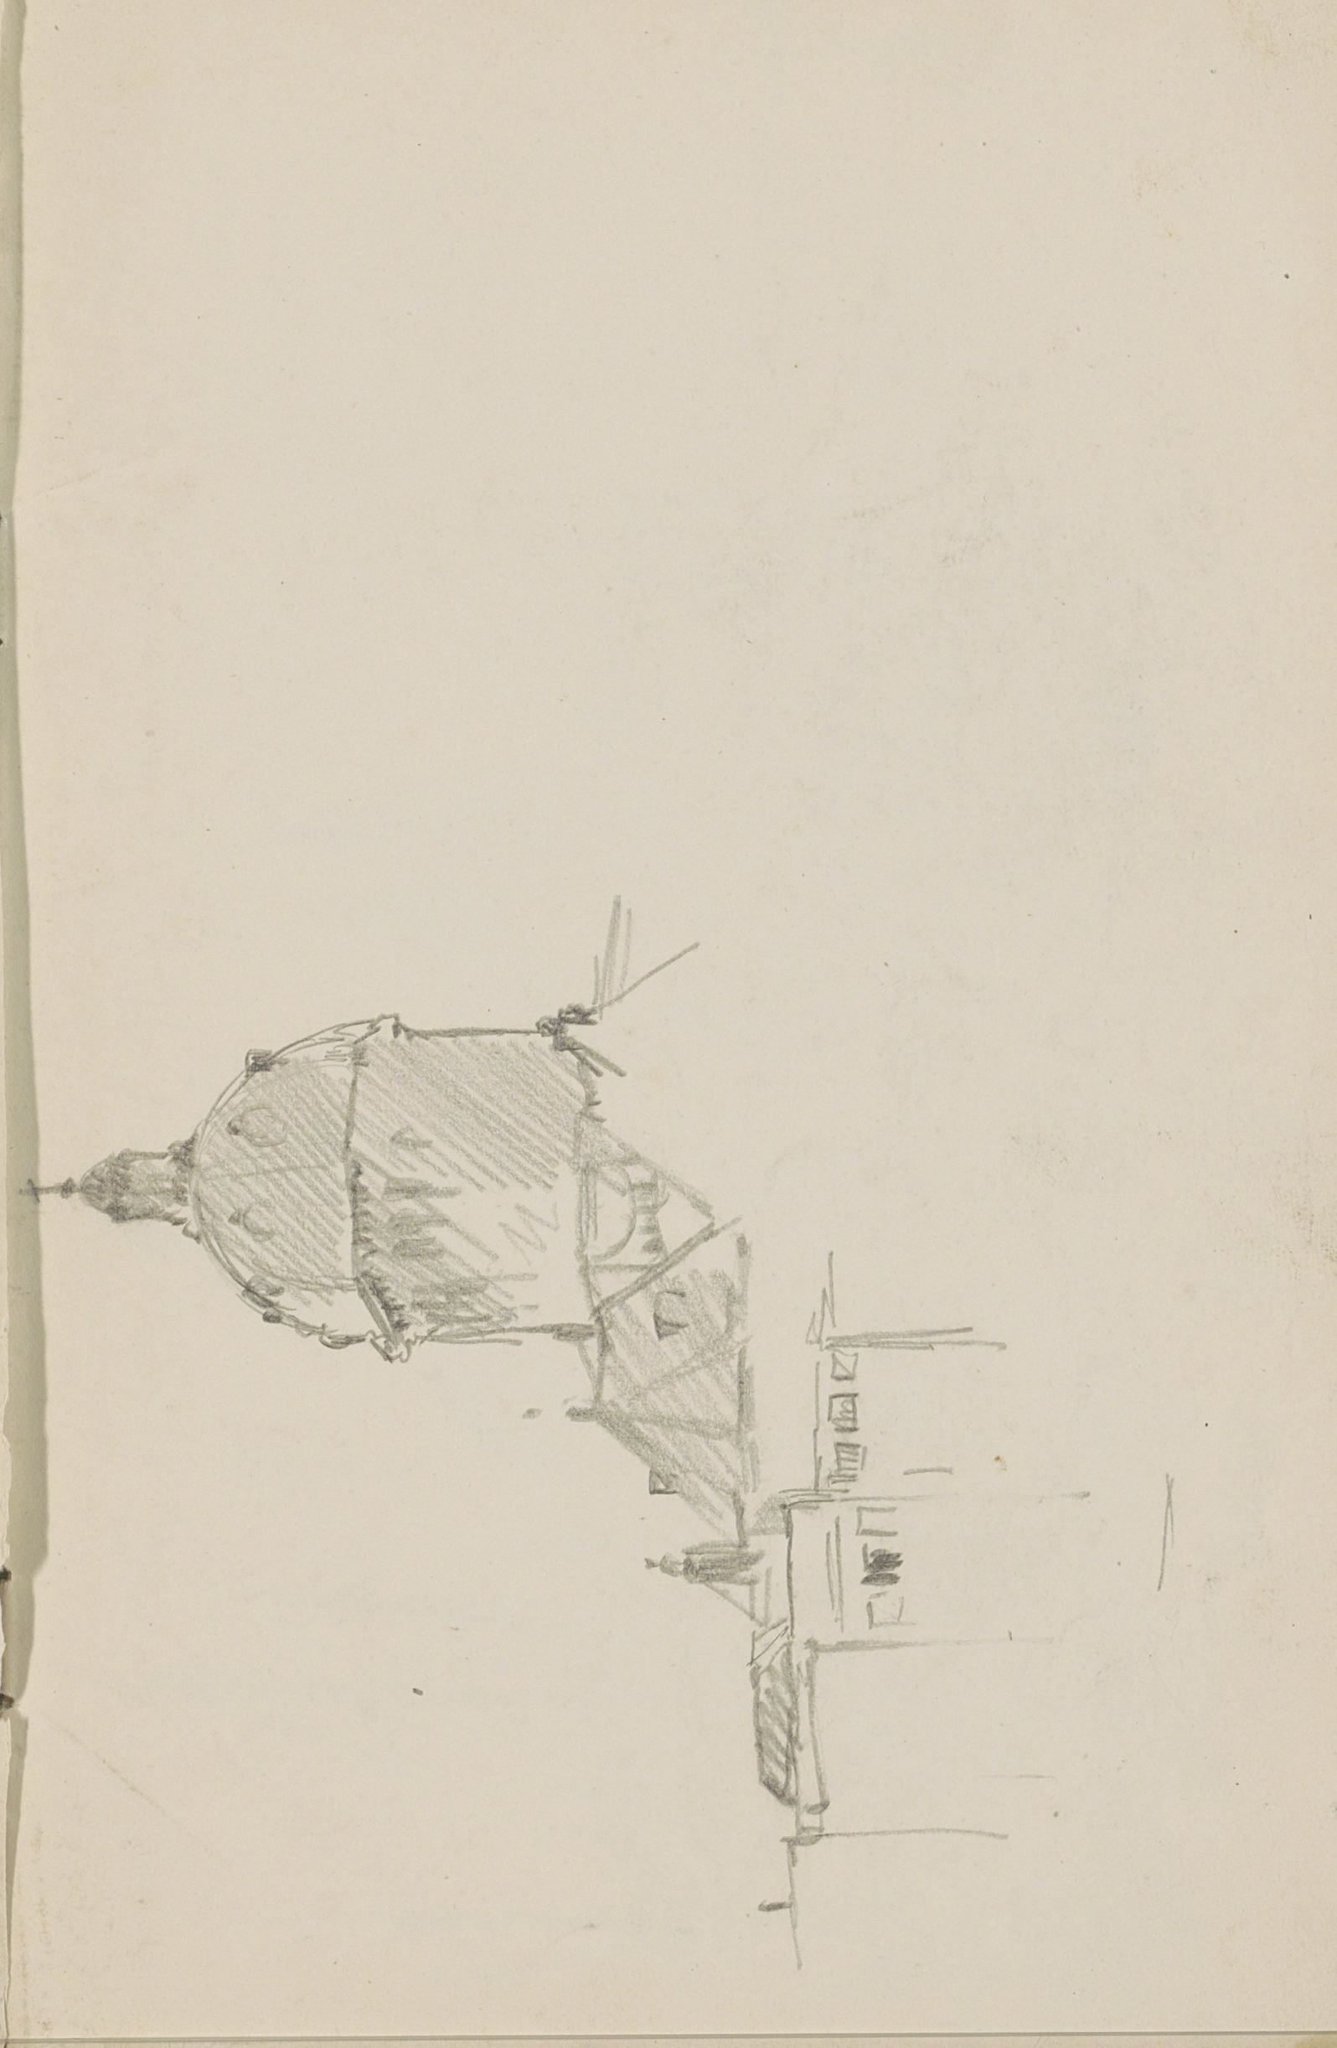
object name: sketchbook leaf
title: Gebouw met een koepeltoren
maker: cornelis vreedenburgh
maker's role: draughtsman, print maker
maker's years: 1880-1946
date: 1890-1946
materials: paper, pencil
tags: parts of church exterior and annexes (with name)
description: Vermoedelijk een kerk. Blad 18 recto uit een schetsboek met 45 bladen.